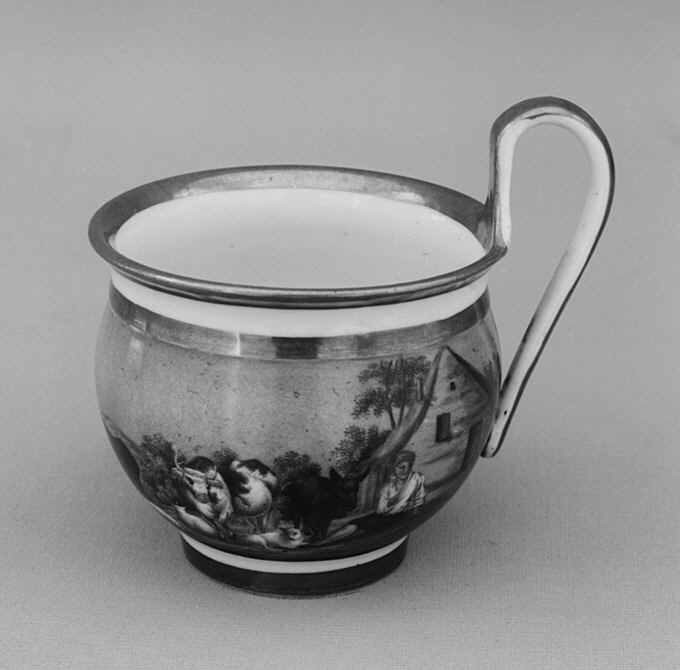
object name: cup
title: Cup (one of six) (part of a set)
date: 1820-1830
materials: hard paste porcelain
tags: human figures,houses,cows